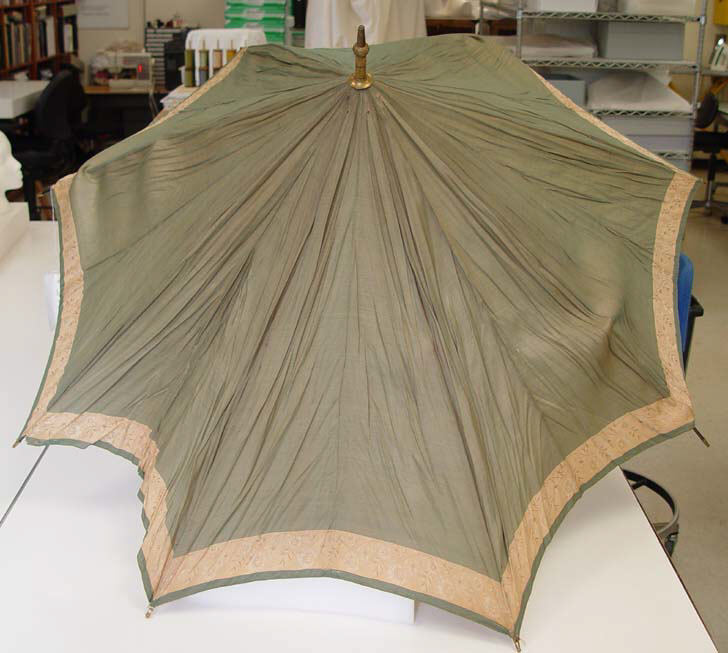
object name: umbrella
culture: british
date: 1801-1833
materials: metal, silk